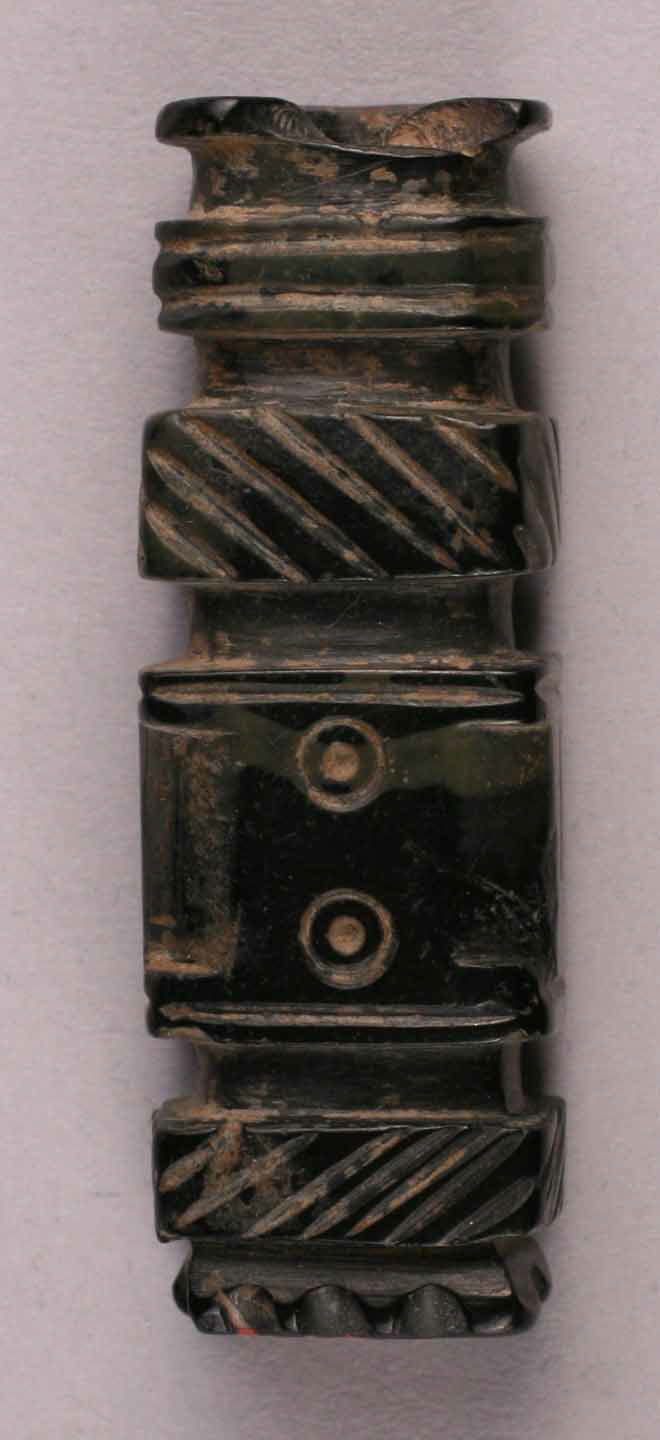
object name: fragment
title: Stone Fragment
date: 801-1000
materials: stone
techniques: carving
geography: iran